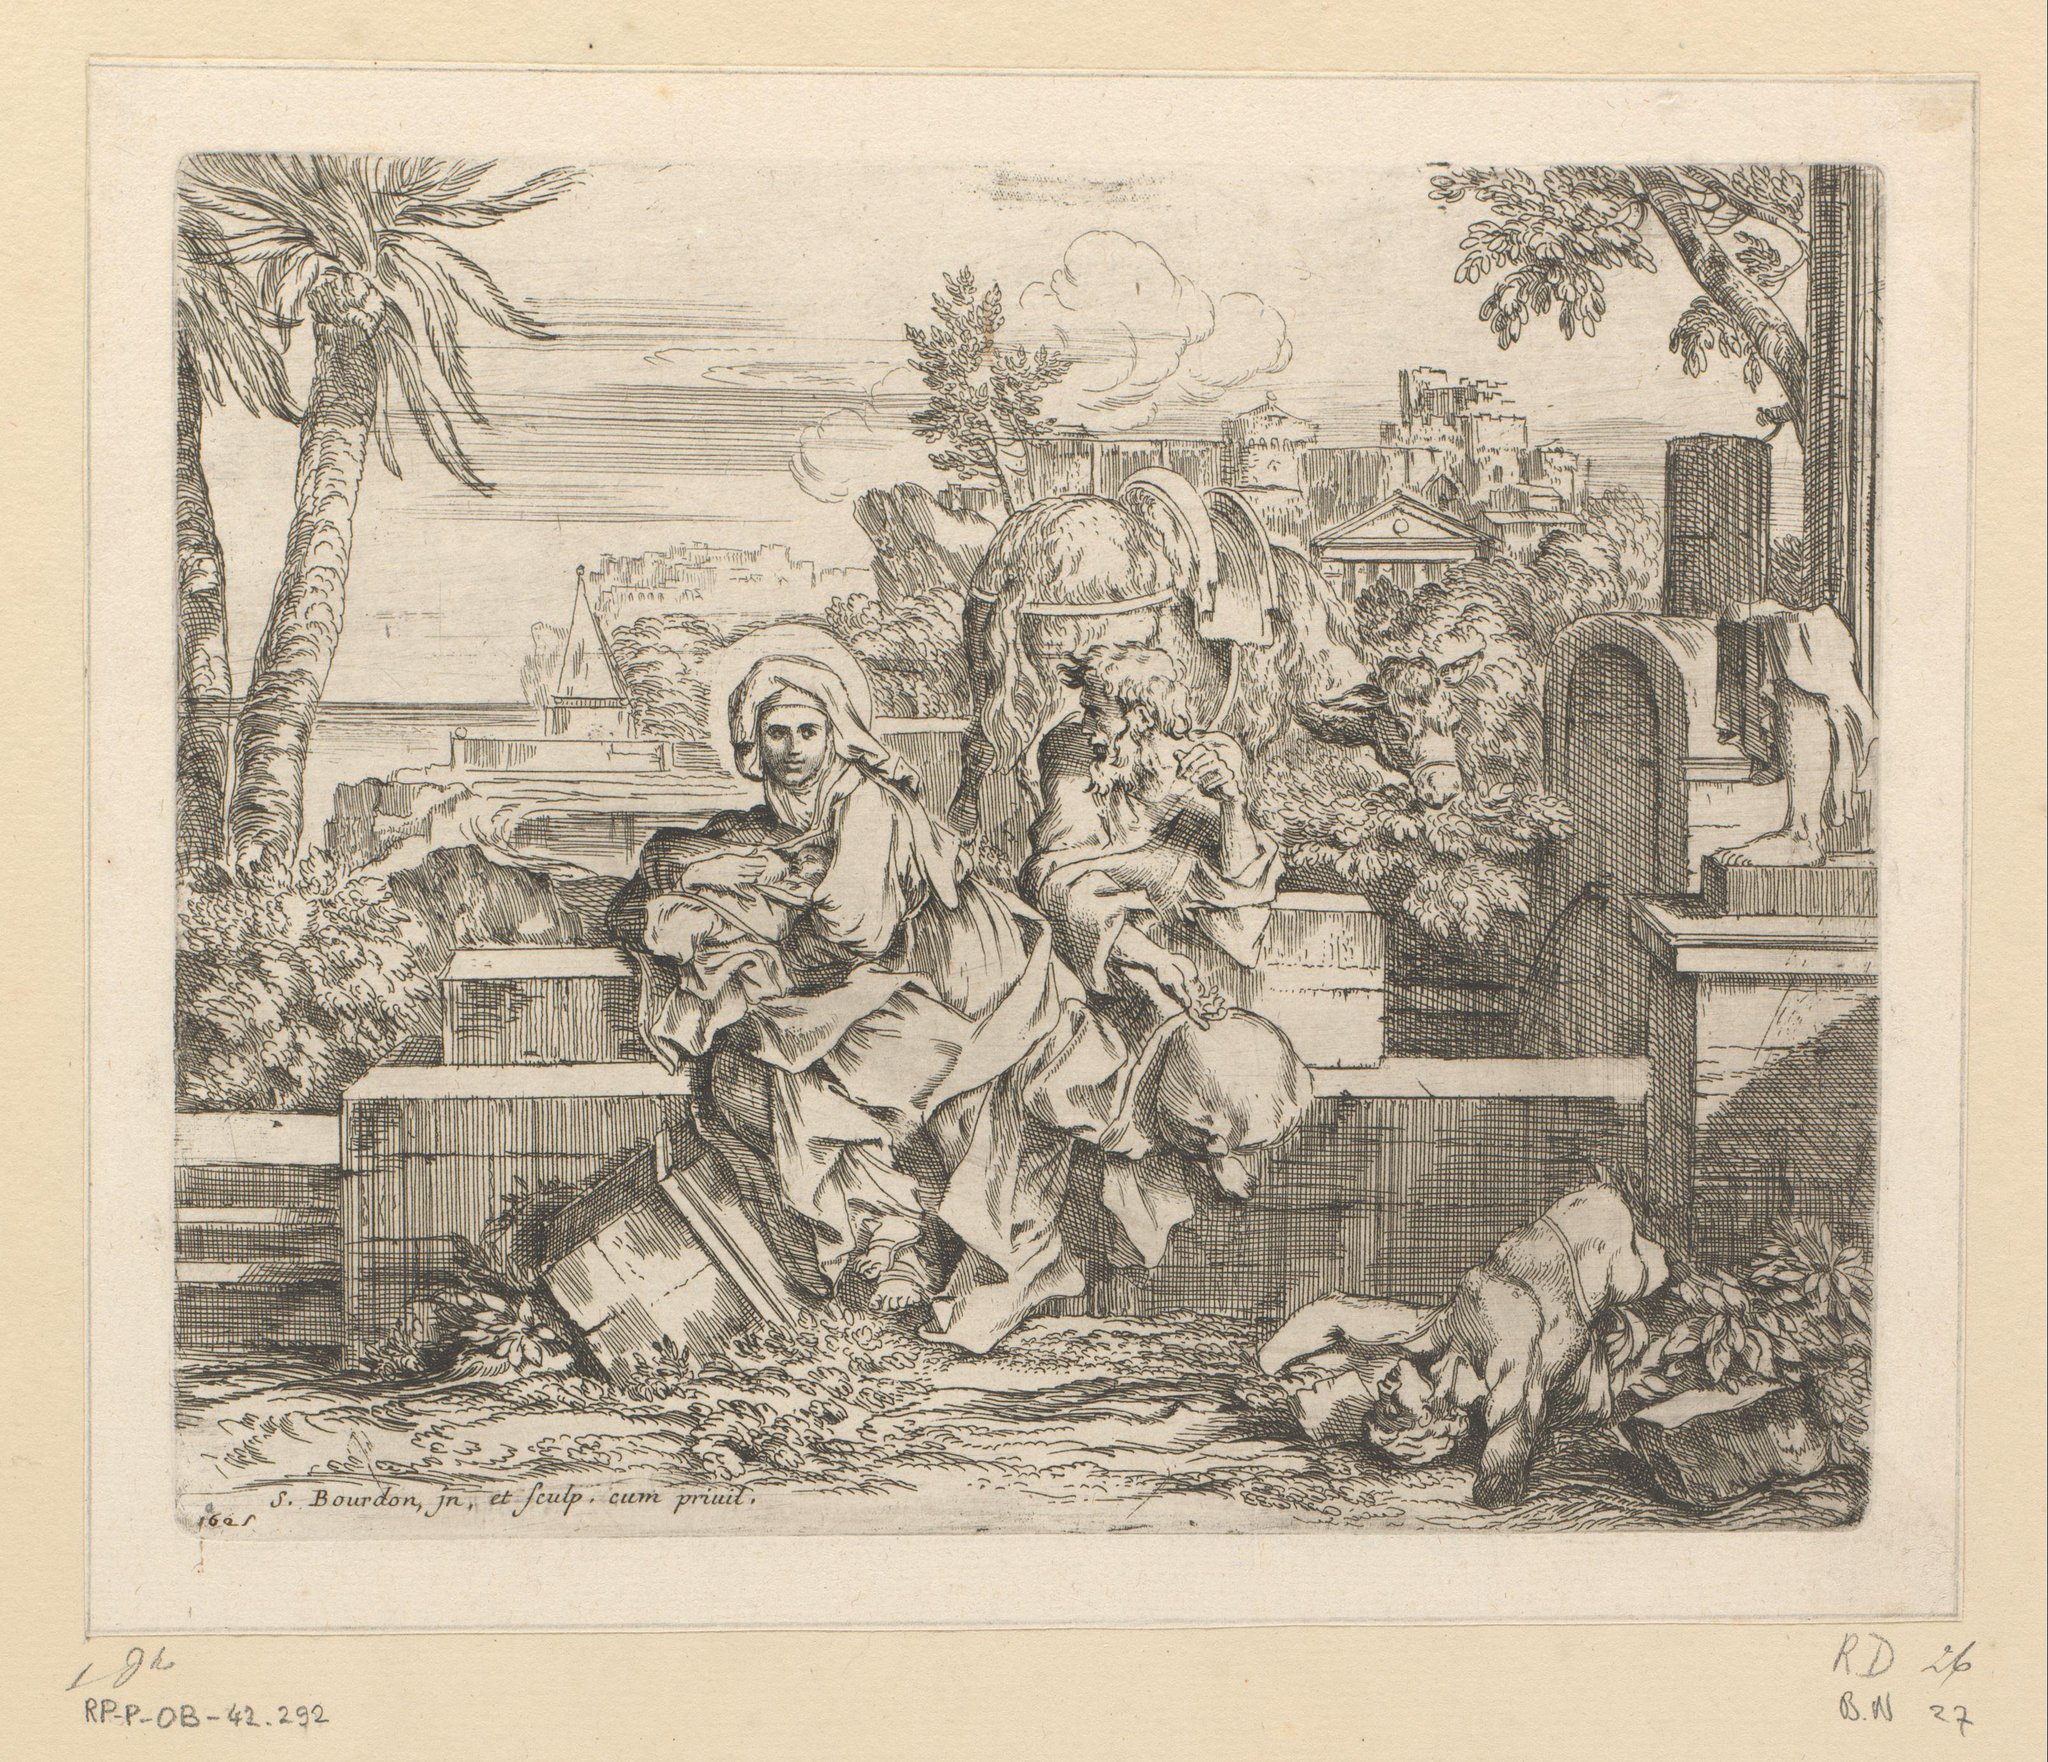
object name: print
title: Taferelen uit de vlucht naar Egypte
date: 1626-1671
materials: paper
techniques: etching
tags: rest on the flight into egypt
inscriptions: inscription: ‘de vlugt van egipten door bourdon / no 45’, number: ‘1625’, collector's mark: Lugt 240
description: Maakt deel uit van een serie van zes prenten met taferelen uit de vlucht naar Egypte.